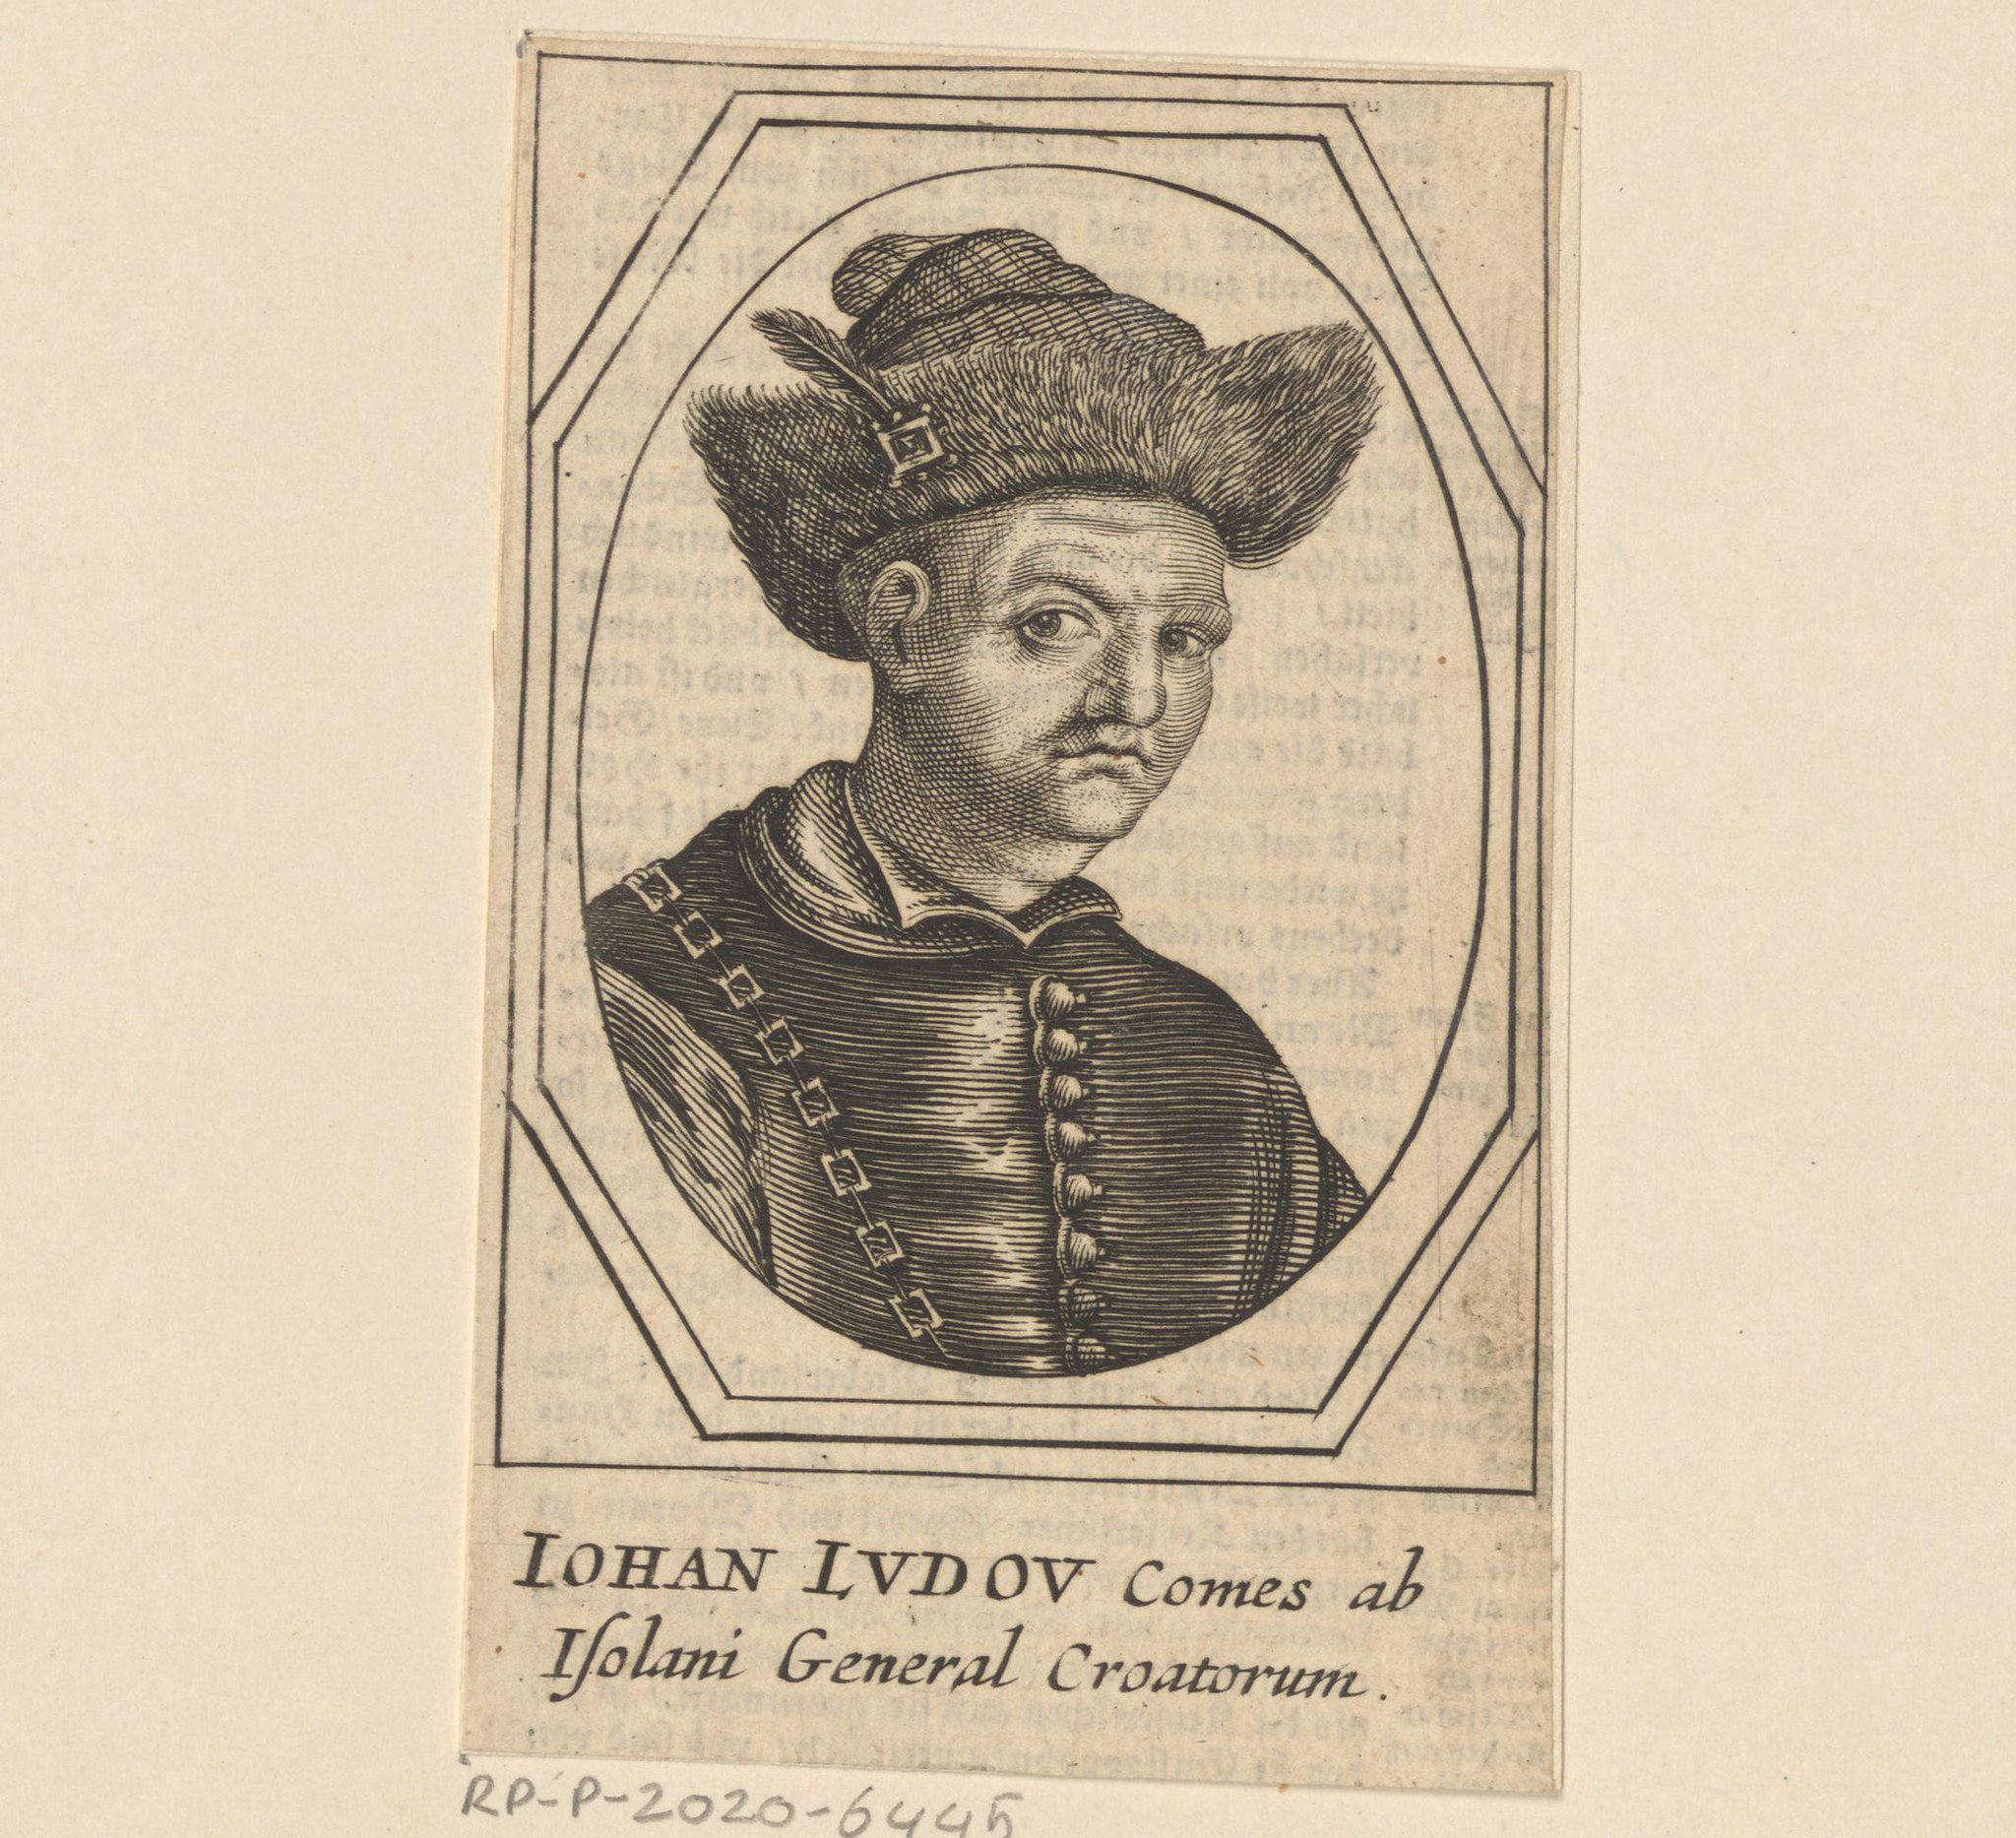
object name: book illustration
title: Portret van Johann Ludwig Hector, graaf van Isolani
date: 1647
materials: paper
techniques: engraving, letterpress printing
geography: frankfurt am main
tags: head-gear, commander-in-chief, general, marshal, historical persons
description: Prent uit: Wassenberg, Eberhard. Der erneuerte teutsche Florus (...). Frankfurt am Main: Anton Humm, 1647.